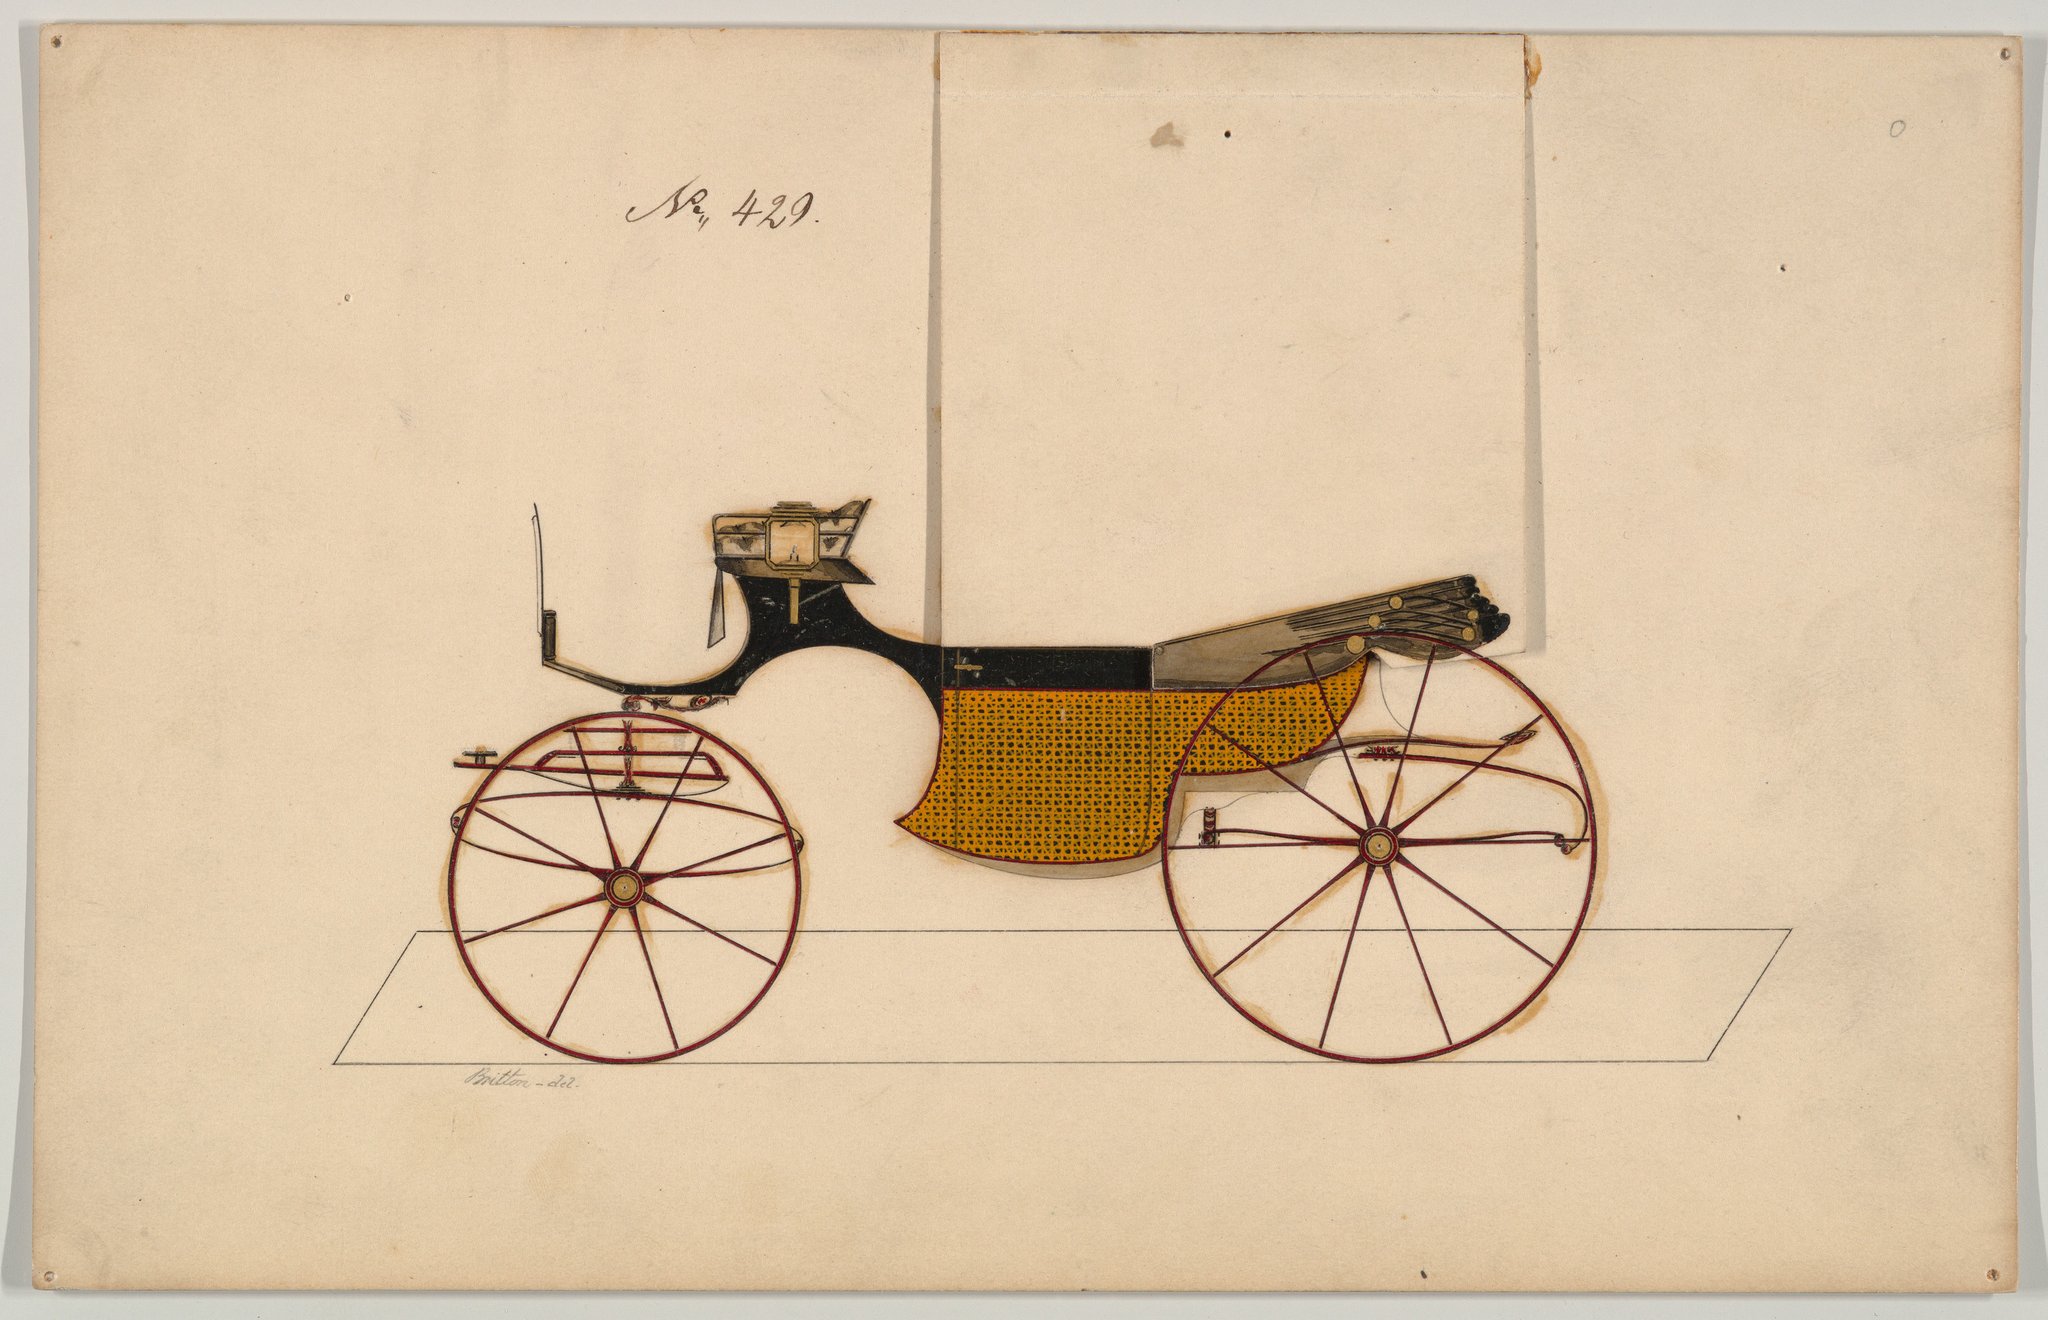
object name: drawing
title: Landaulet #429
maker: brewster & co.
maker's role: manufacturer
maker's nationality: american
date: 1850-1870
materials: gouache, gum arabic, ink, watercolor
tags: carriages